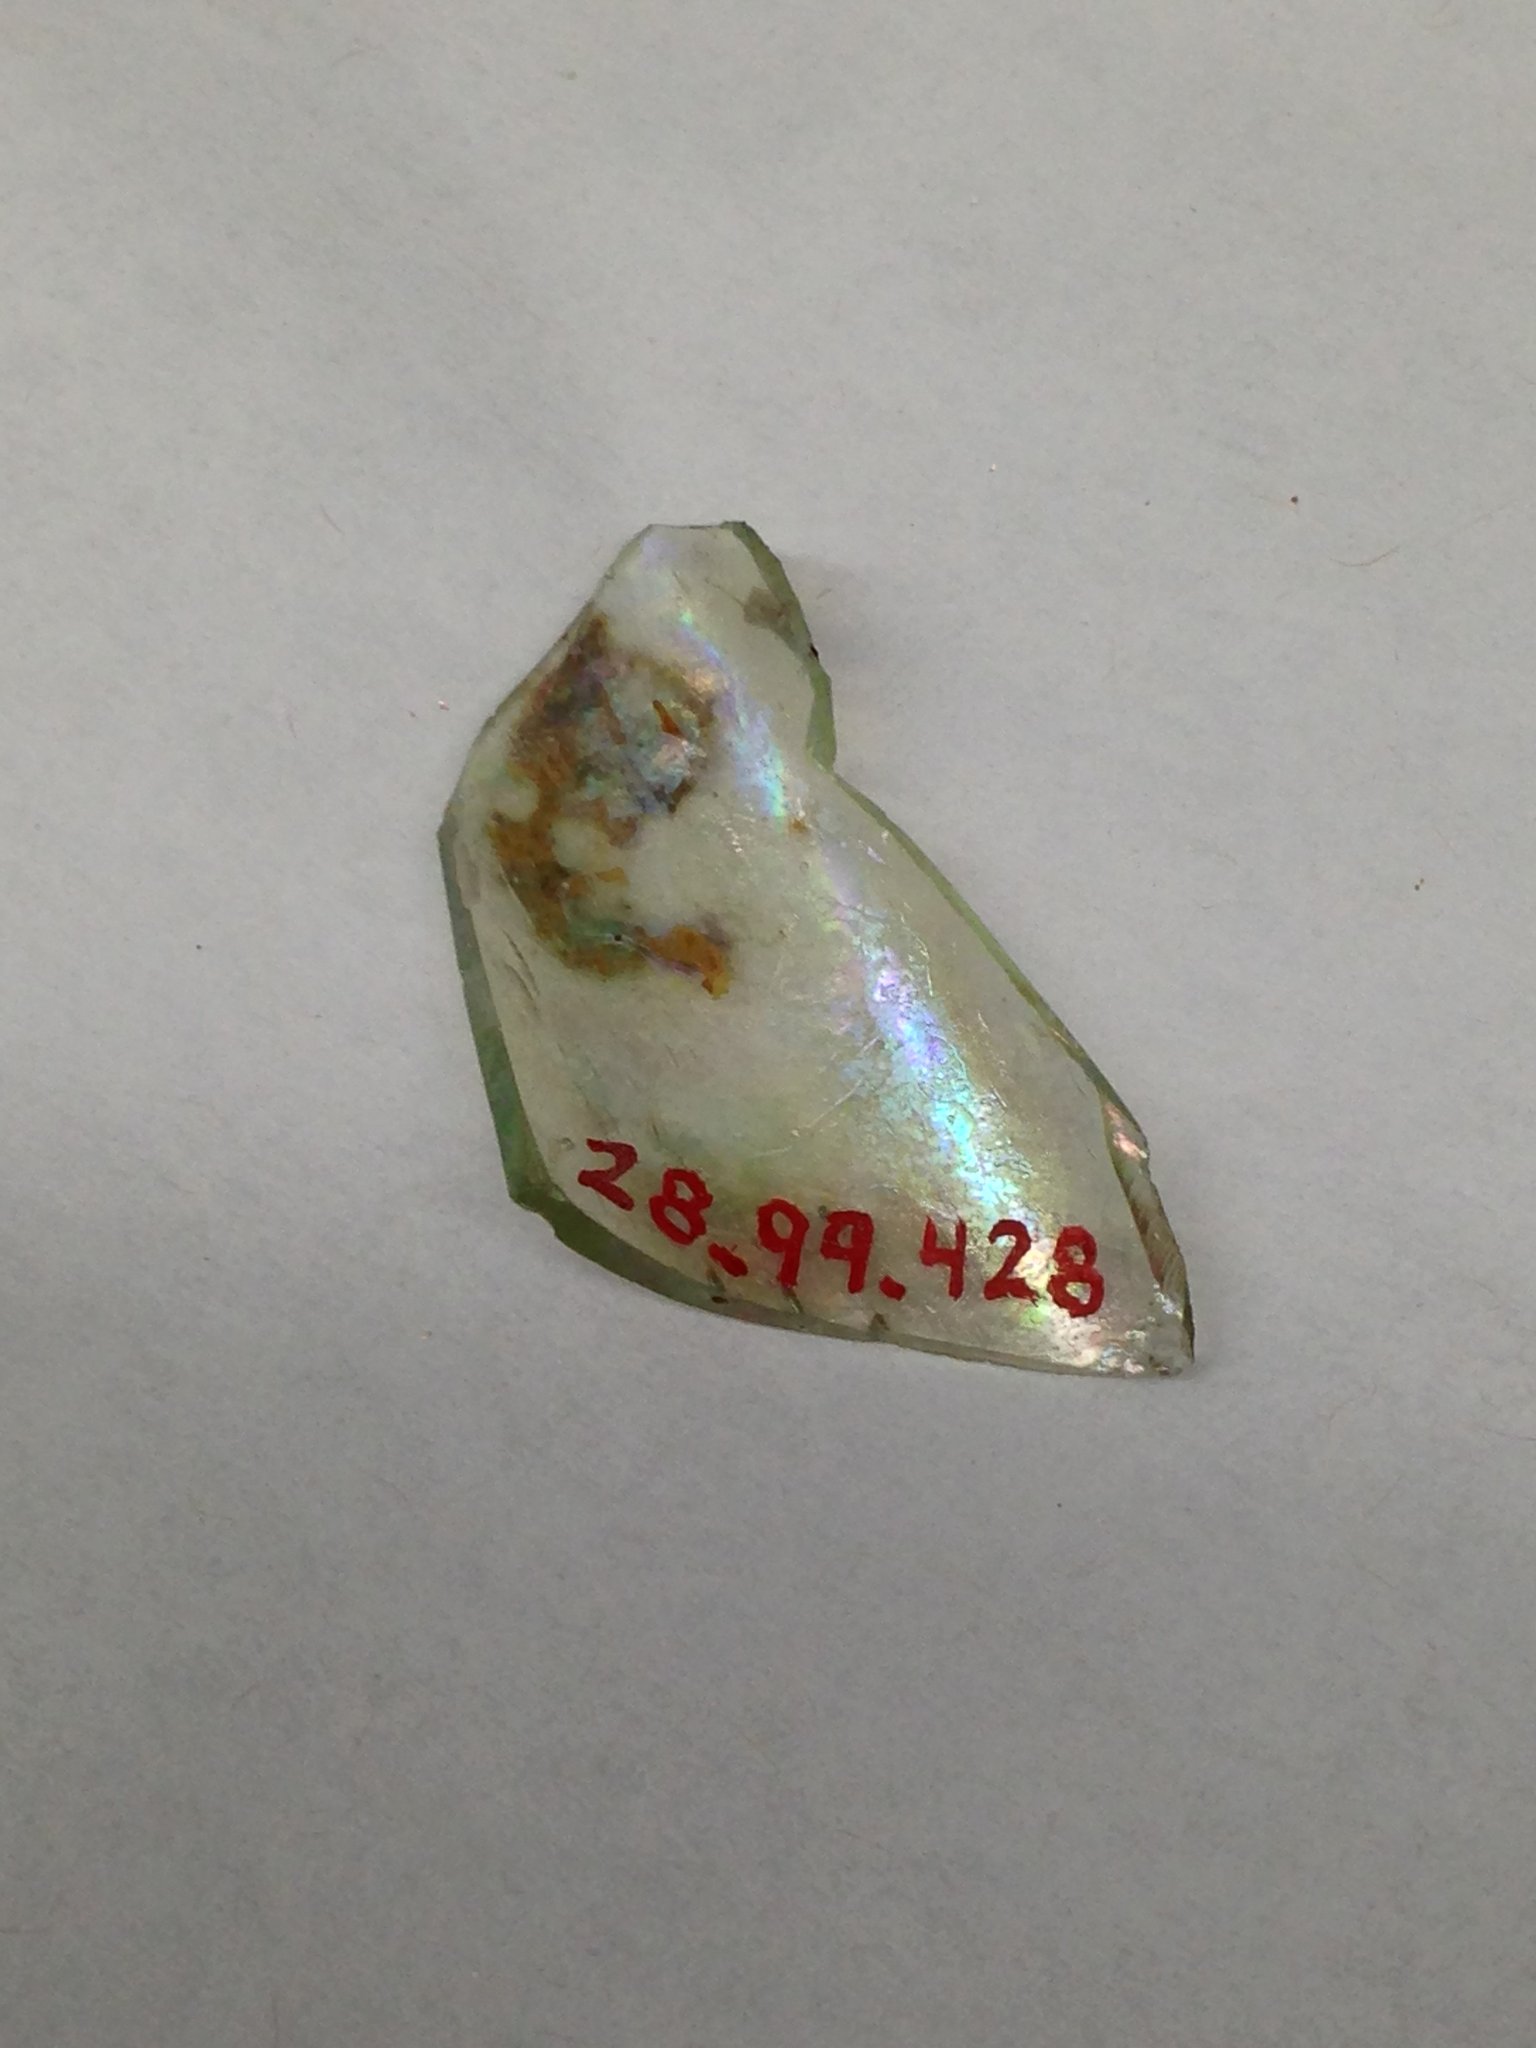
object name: fragment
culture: european or middle eastern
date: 1150-1250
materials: ceramic, glass